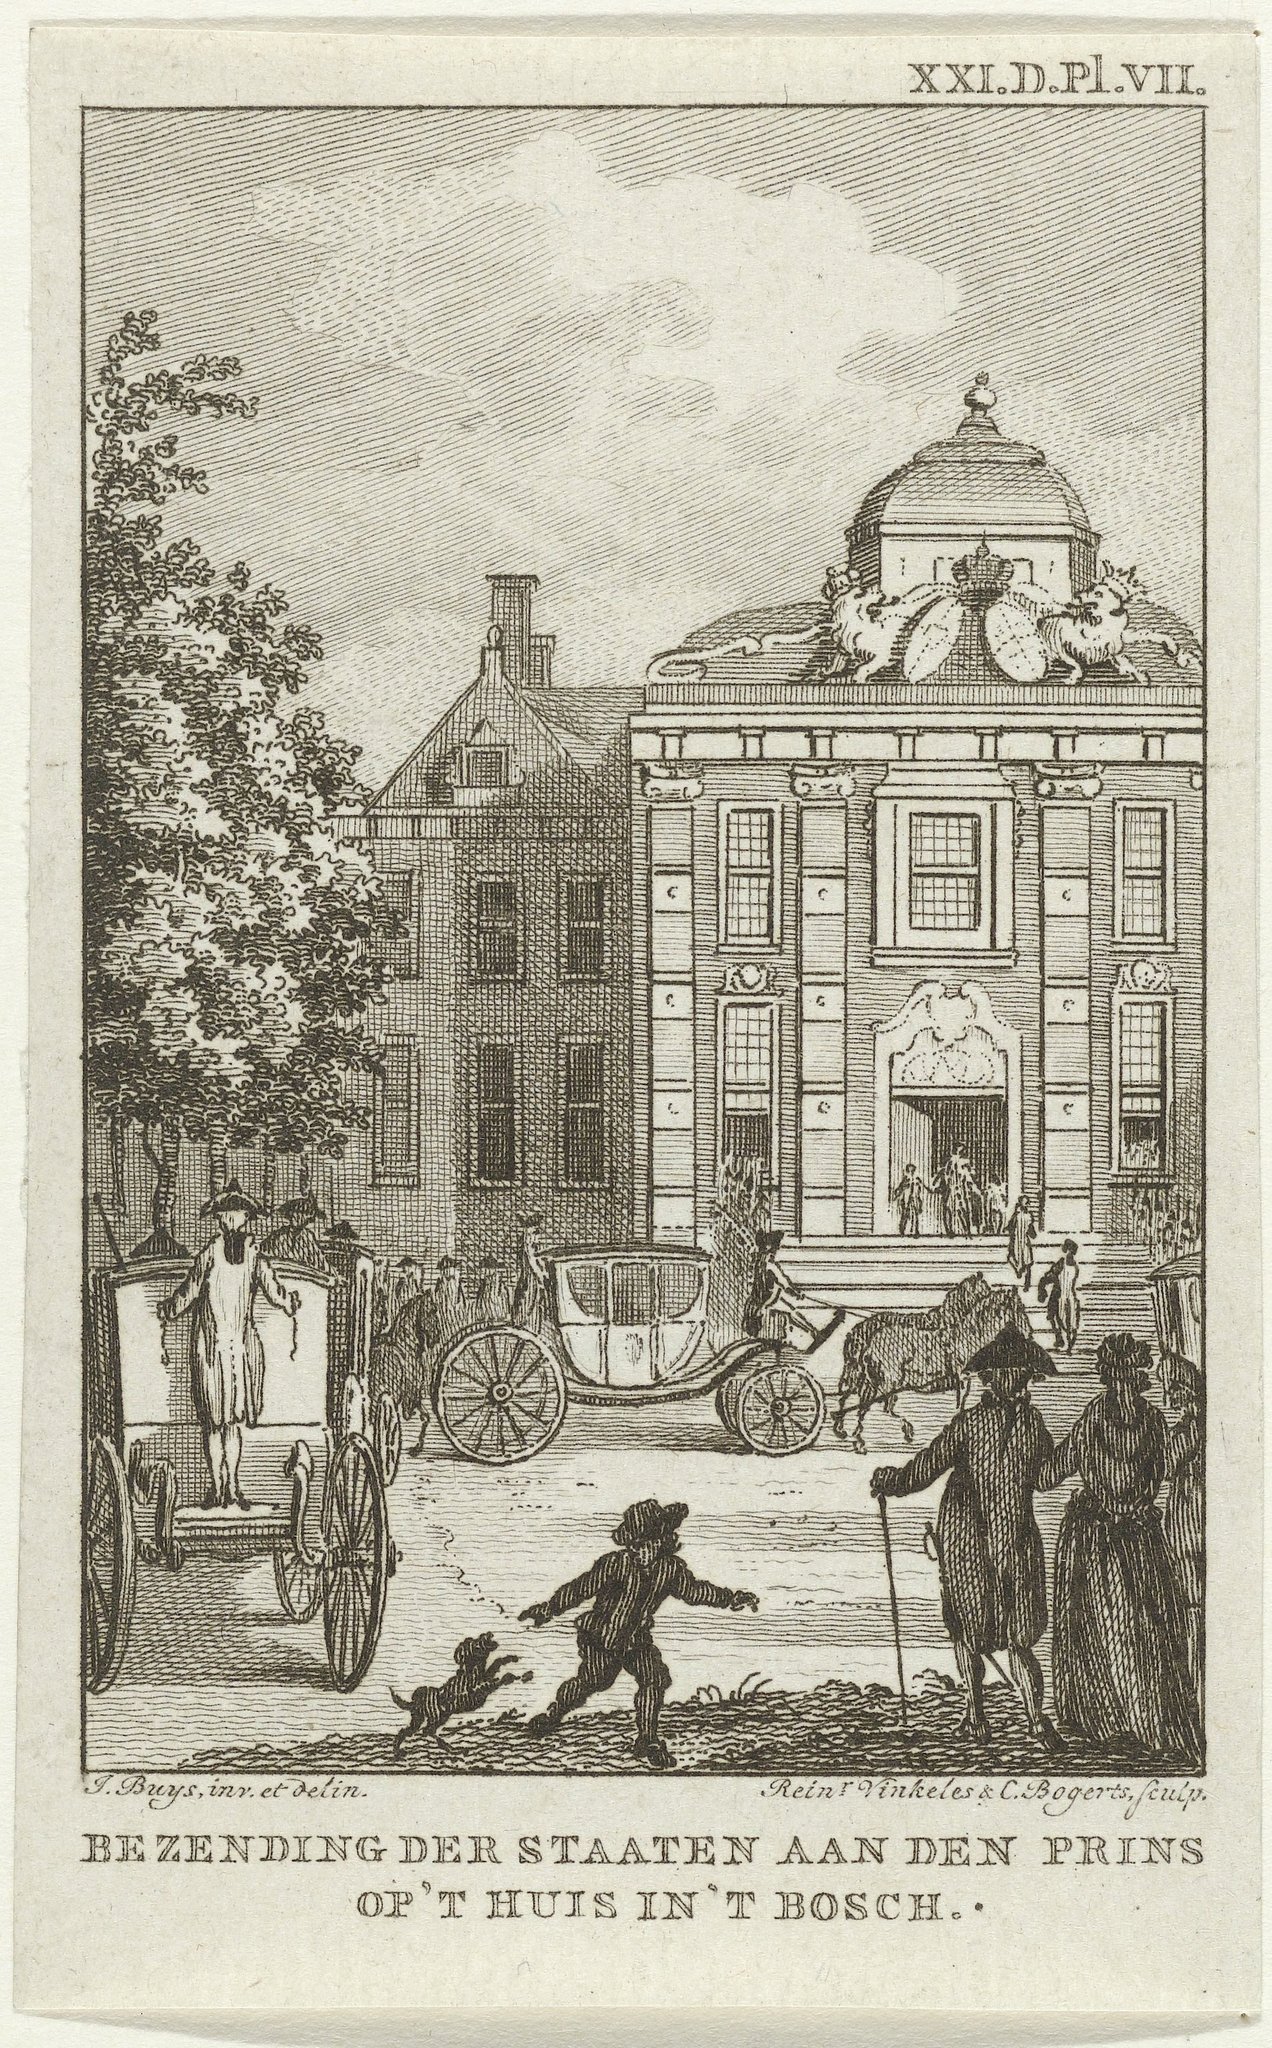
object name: print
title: Bezending der Staaten aan den Prins op 't Huis in 't Bosch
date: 1788-1795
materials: paper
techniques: engraving, etching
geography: northern netherlands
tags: the hague, william v (prince of orange)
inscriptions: collector's mark: Lugt 2228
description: Aankomst van de afvaardiging van de Staten-Generaal bij Paleis Huis ten Bosch voor de presentatie van de Acte van Garantie aan stadhouder Willem V, 10 juli 1788. Gemerkt rechtsboven: XXI.D.Pl.VII.